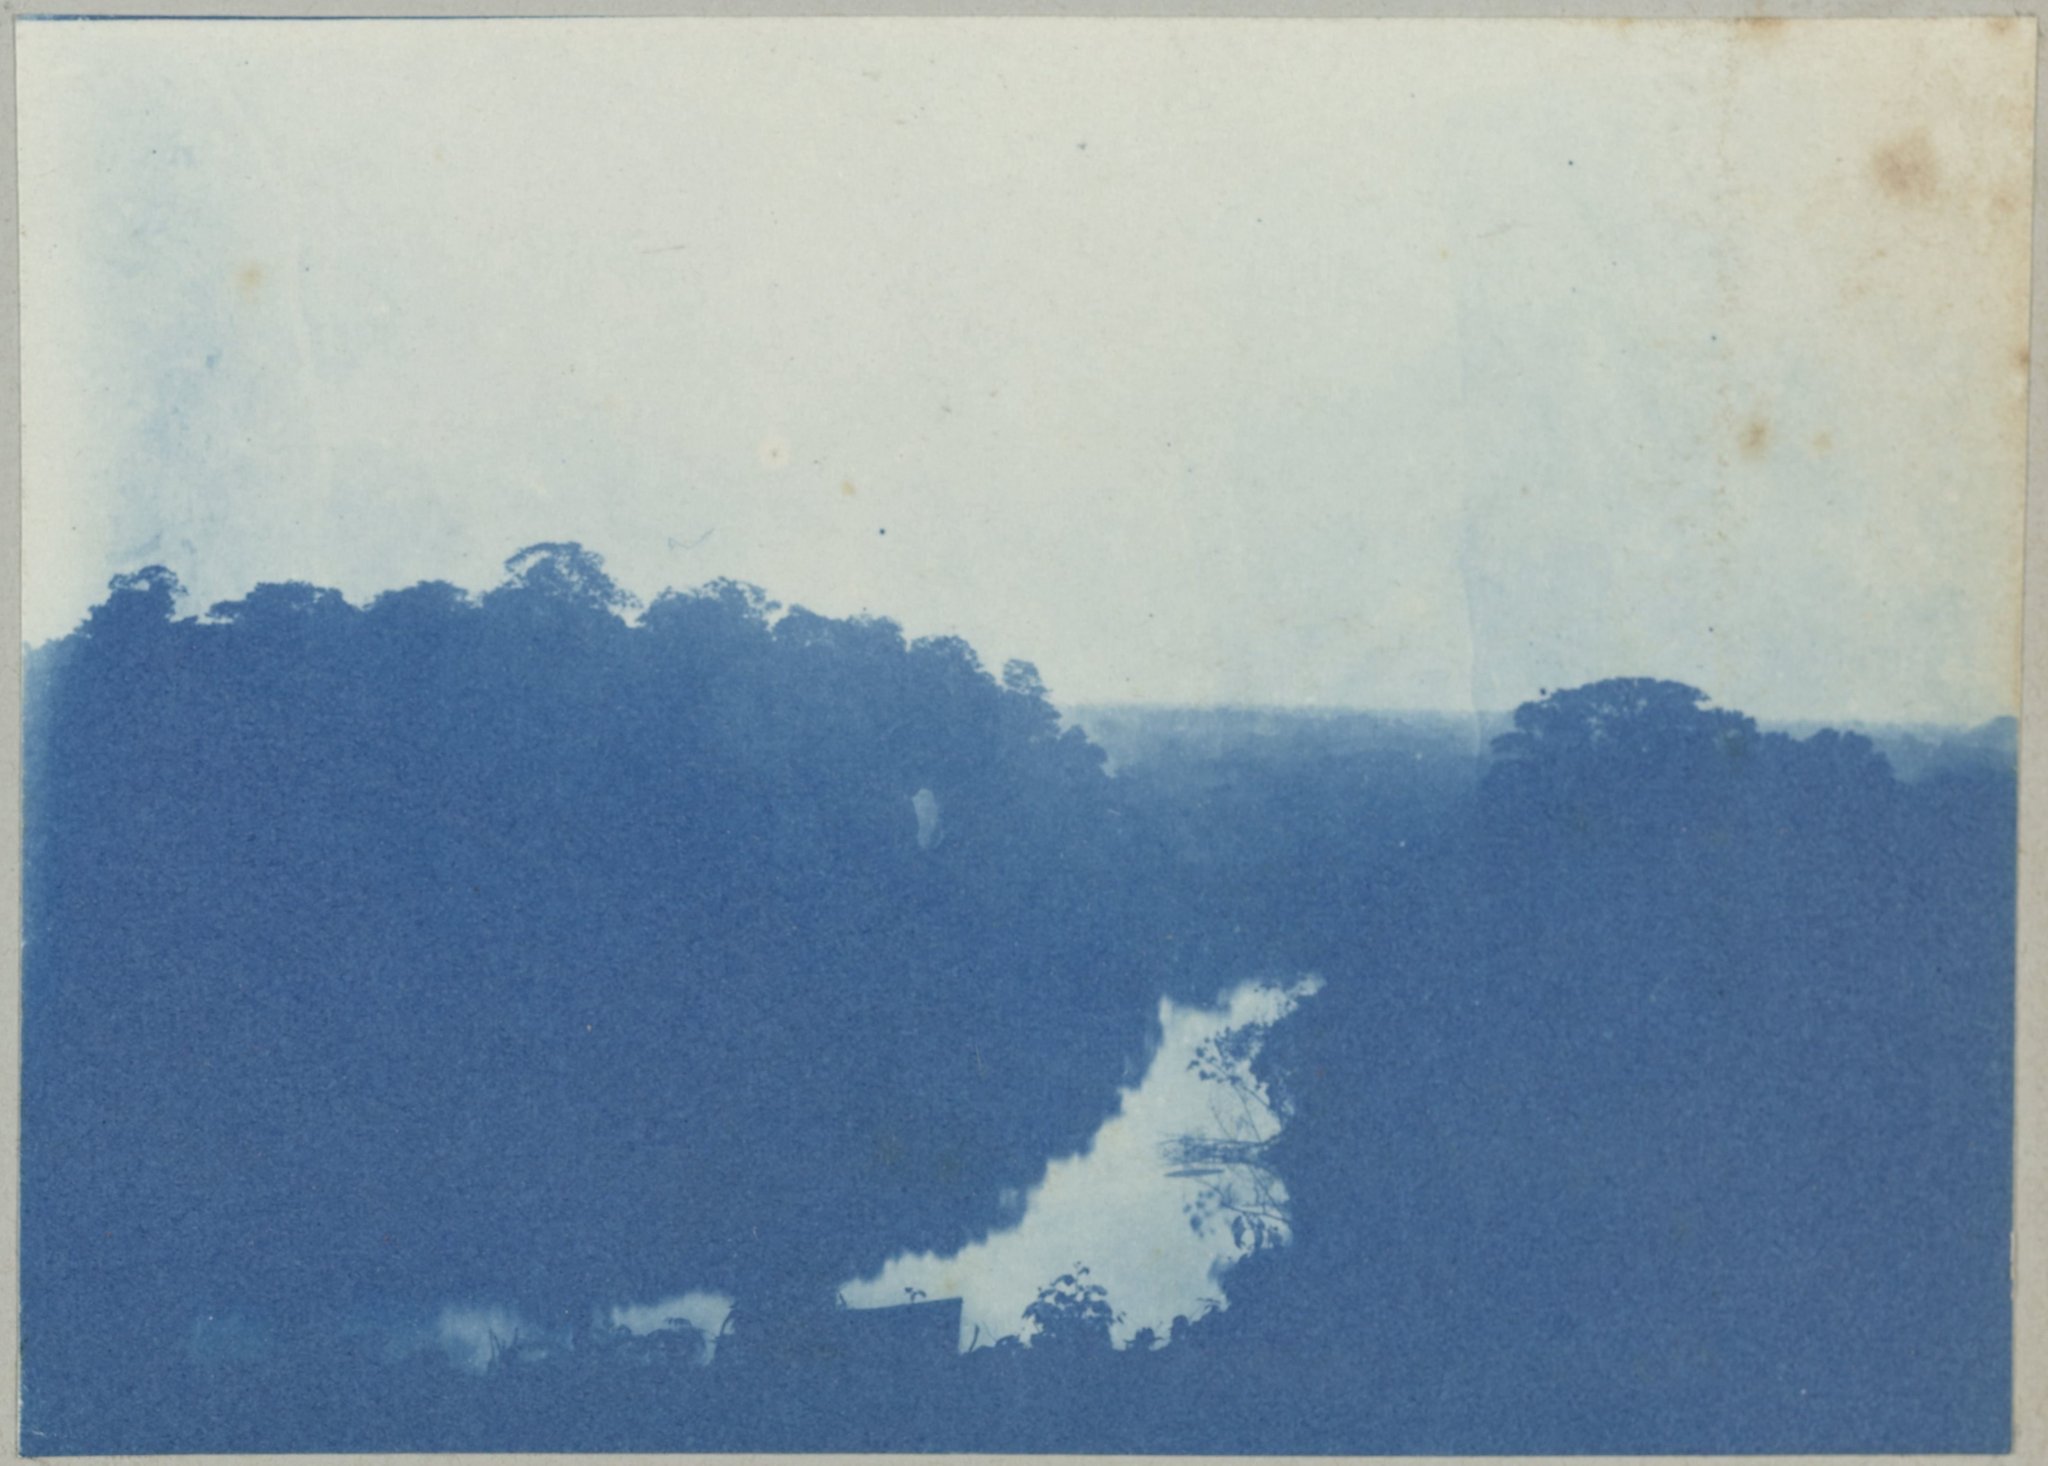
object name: photograph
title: Gezicht van den Mäabotop op de Saramacca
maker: hendrik doijer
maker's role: engineer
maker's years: 1863-1925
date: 1903-1910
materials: photographic support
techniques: cyanotype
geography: suriname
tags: suriname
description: Gezicht vanaf de top van de Maabo Heuvel op de Saramacca Rivier. Onderdeel van het fotoalbum Souvenir de Voyage (deel 1), over het leven van de familie Doijer in en rond de plantage Ma Retraite in Suriname in de jaren 1903-1910.